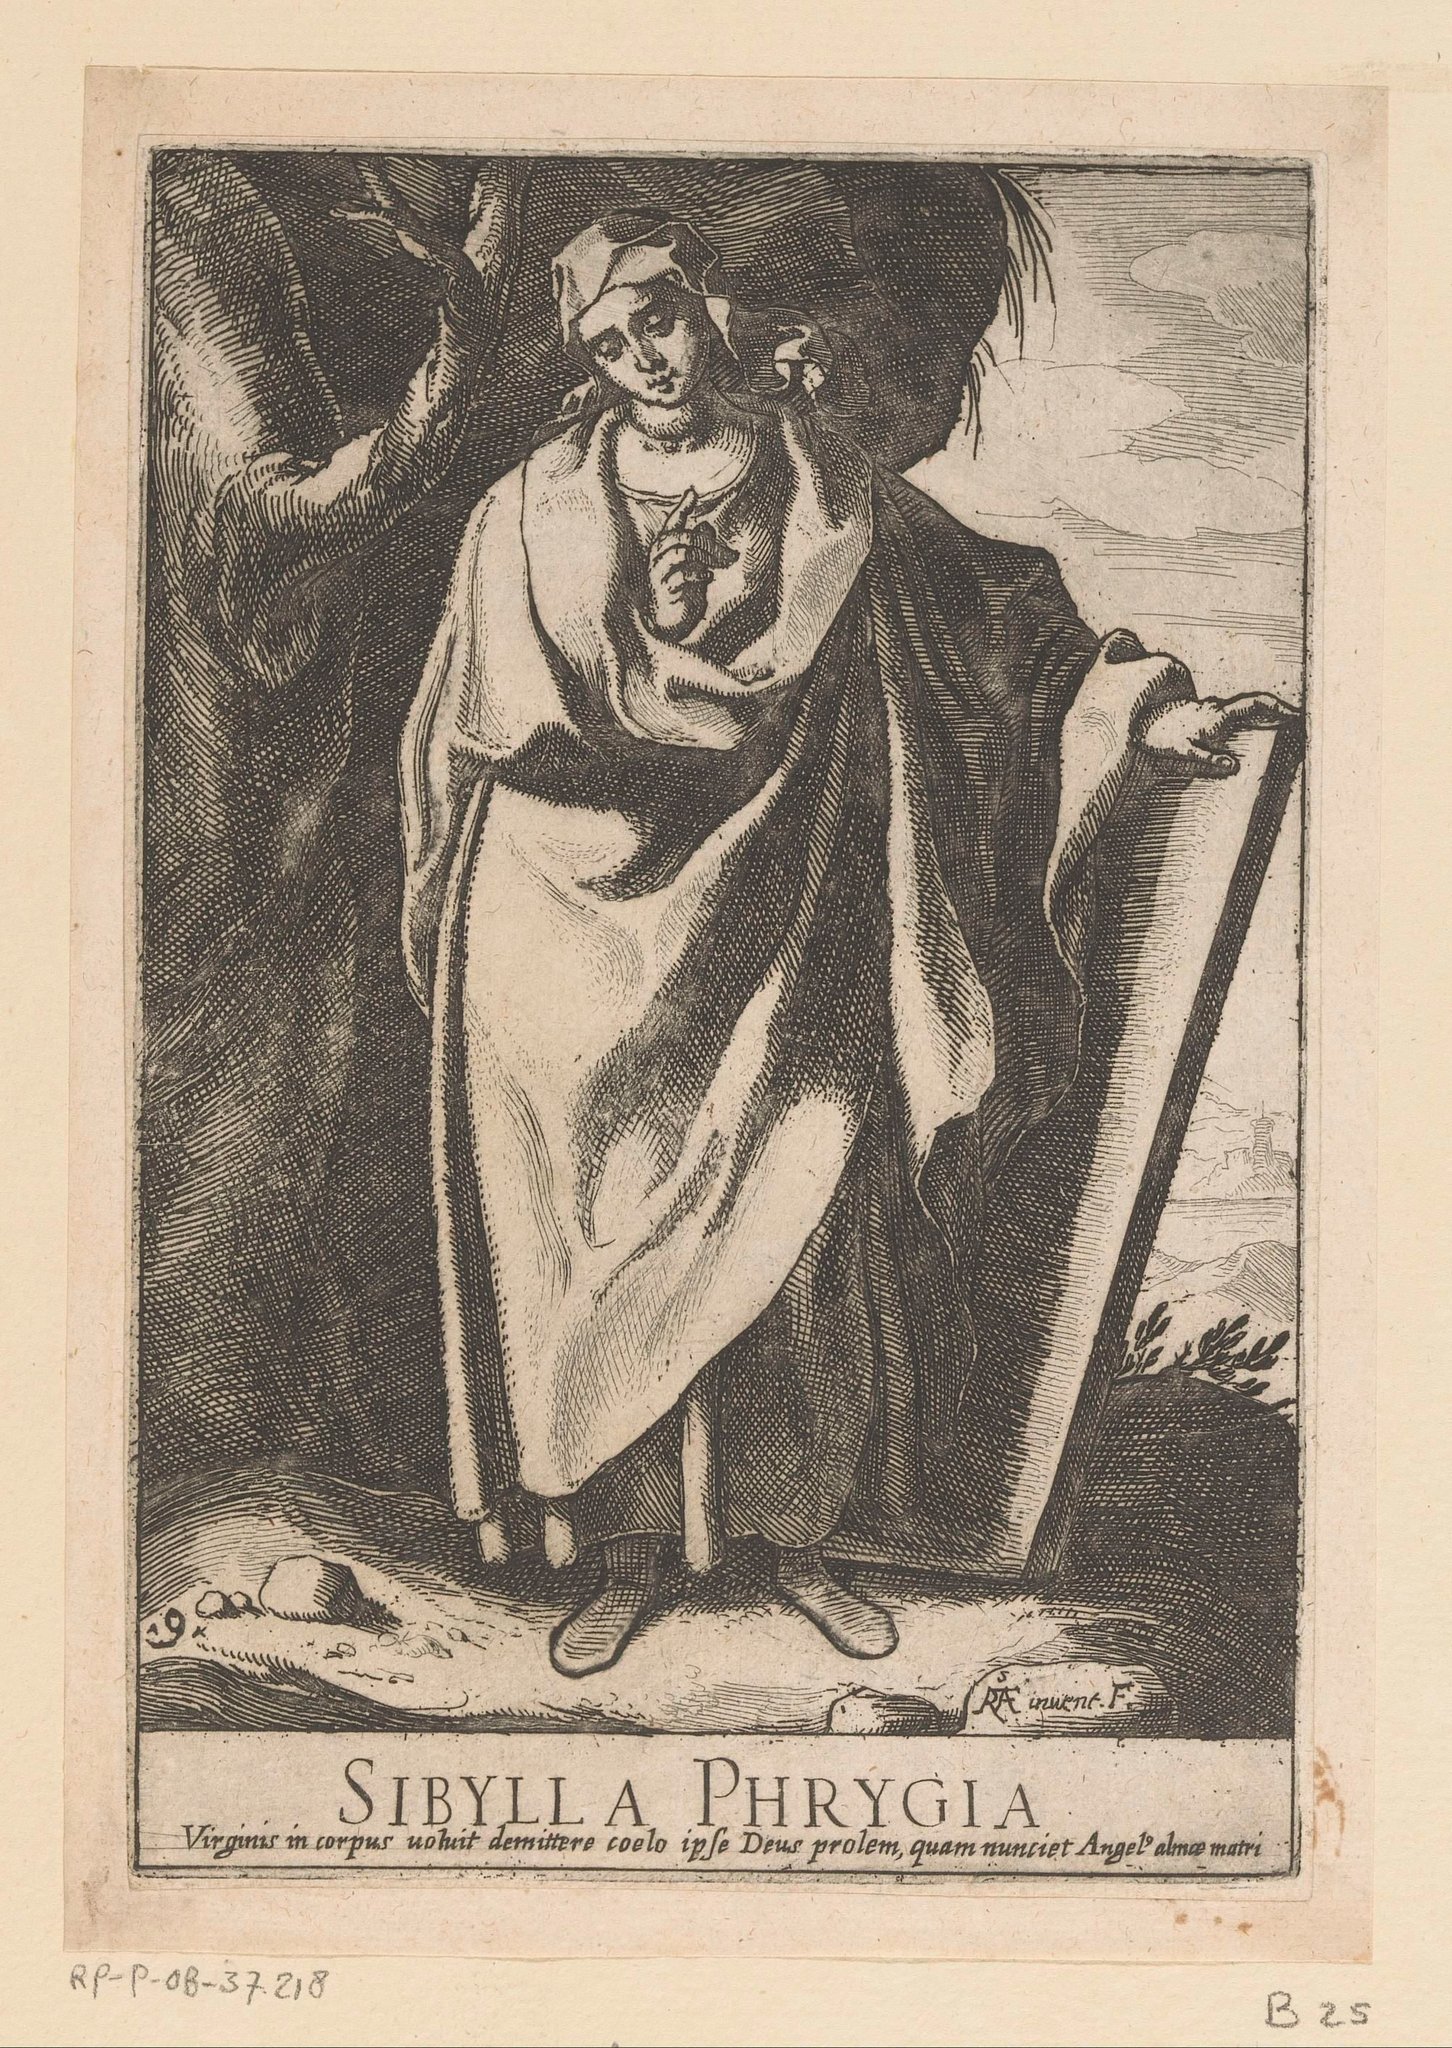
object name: print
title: Sibillaru decem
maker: raffaello schiaminossi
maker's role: painter, print maker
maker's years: 1572-1622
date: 1606-1609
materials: paper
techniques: etching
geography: italy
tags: writing tablets, sibyls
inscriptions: collector's mark: Lugt 240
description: Deze prent maakt deel uit van een serie bestaande uit een titelprent en tien prenten met voorstellingen van Sibillen. De serie is drie keer uitgegeven: eenmaal in 1606 en tweemaal in 1609 door verschillende uitgevers. Om deze reden worden de prenten uit deze serie hier 1606-1609 gedateerd, behalve indien de individuele prent zelf gedateerd is.